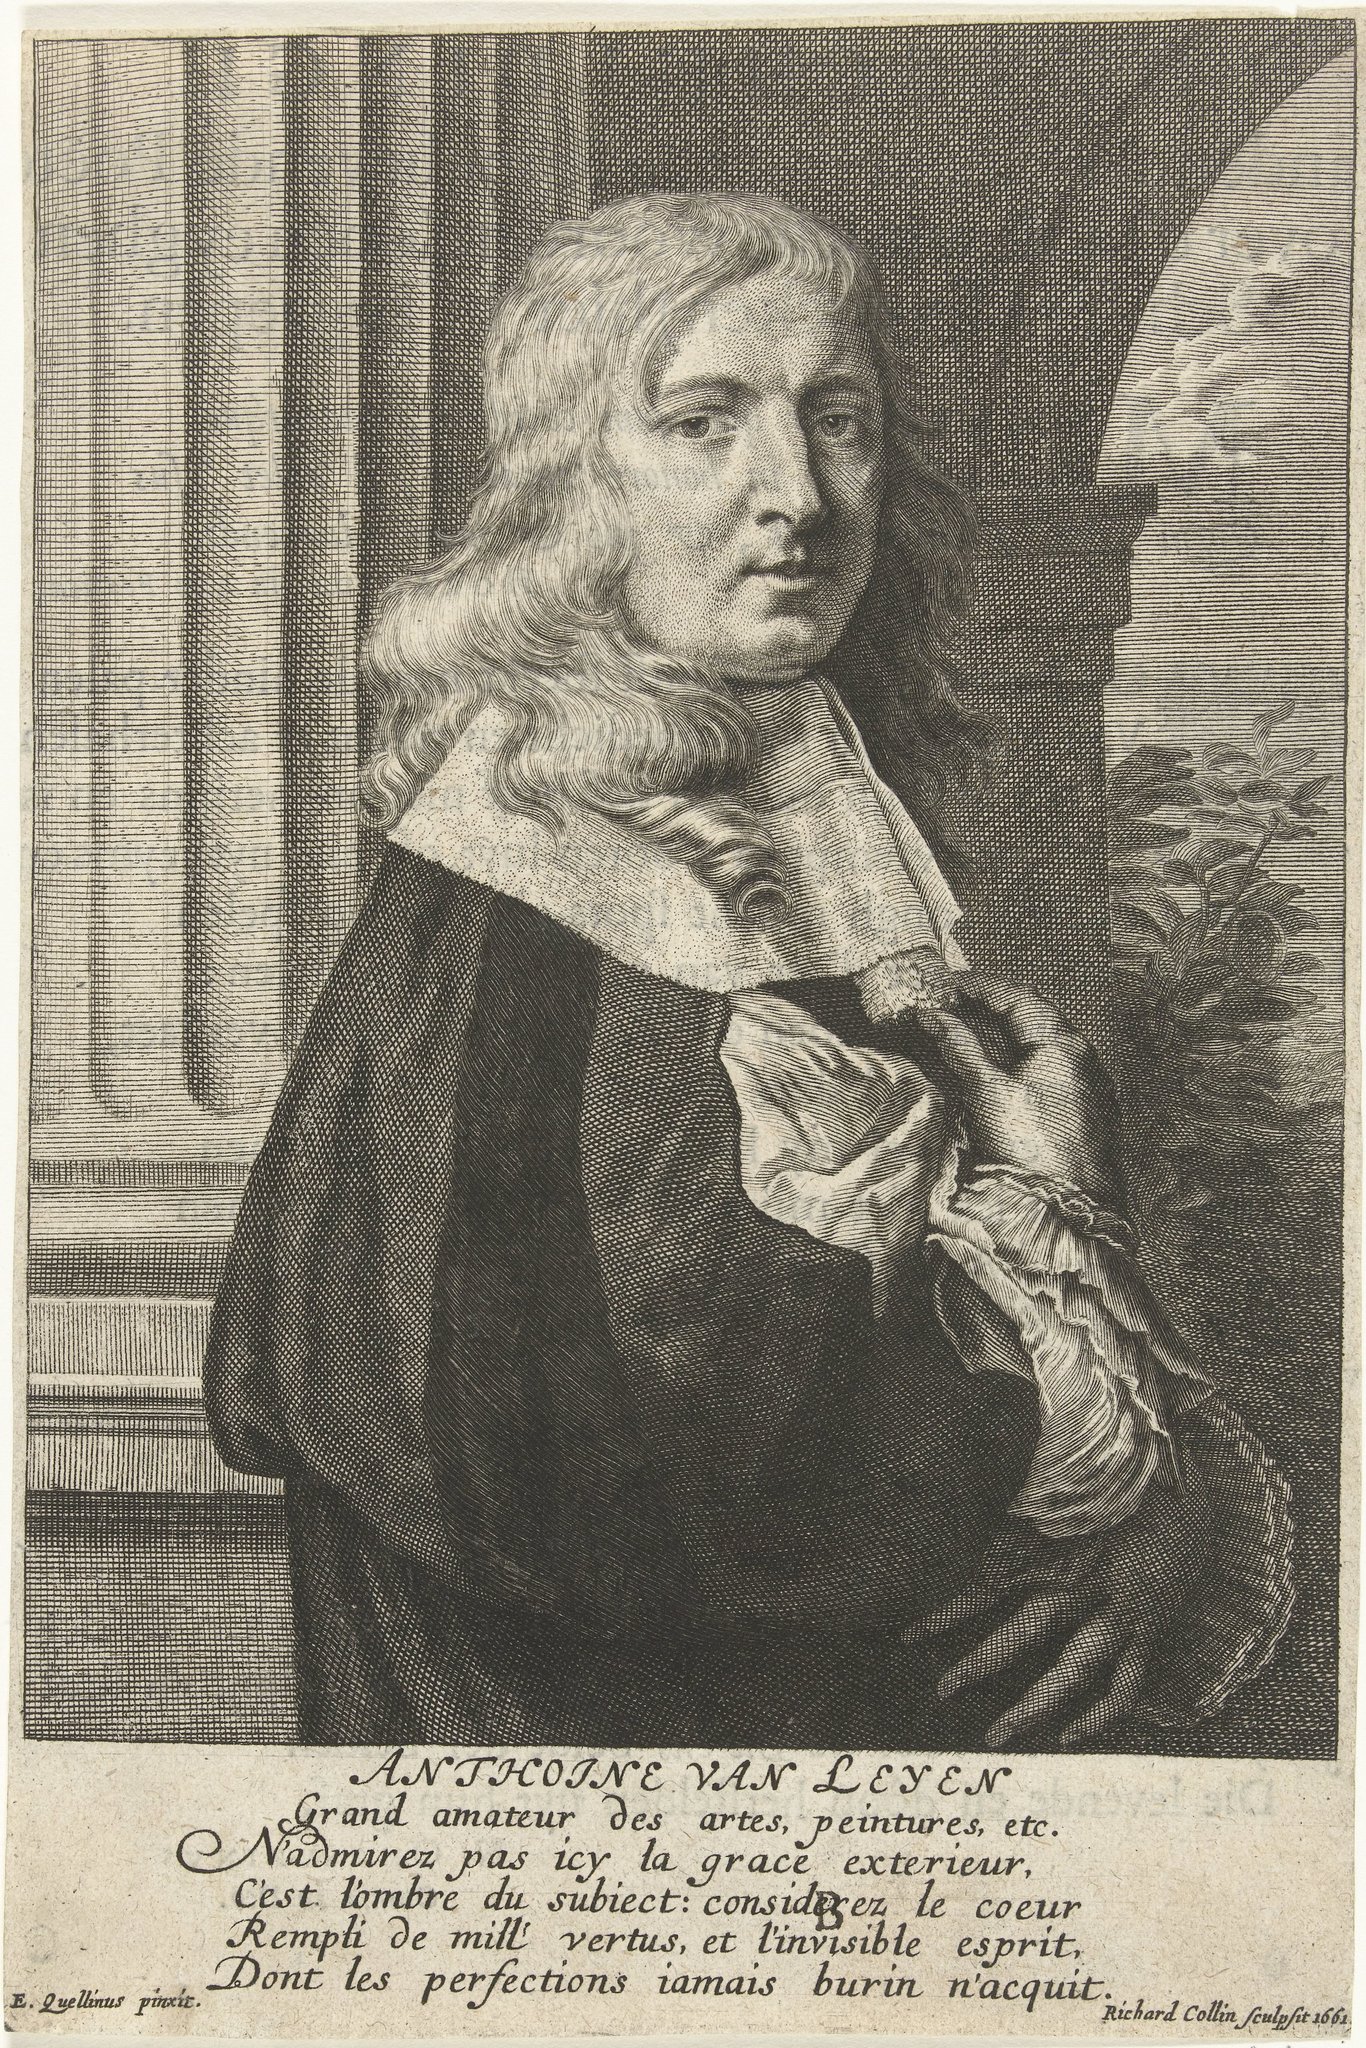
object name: print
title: Portret van de kunstverzamelaar Anton van Leyen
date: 1661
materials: paper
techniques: engraving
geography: antwerp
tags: painter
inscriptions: collector's mark: Lugt 2228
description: Portret van de kunstverzamelaars Anton van Leyen, met een gedicht in het Frans op Van Leyen.